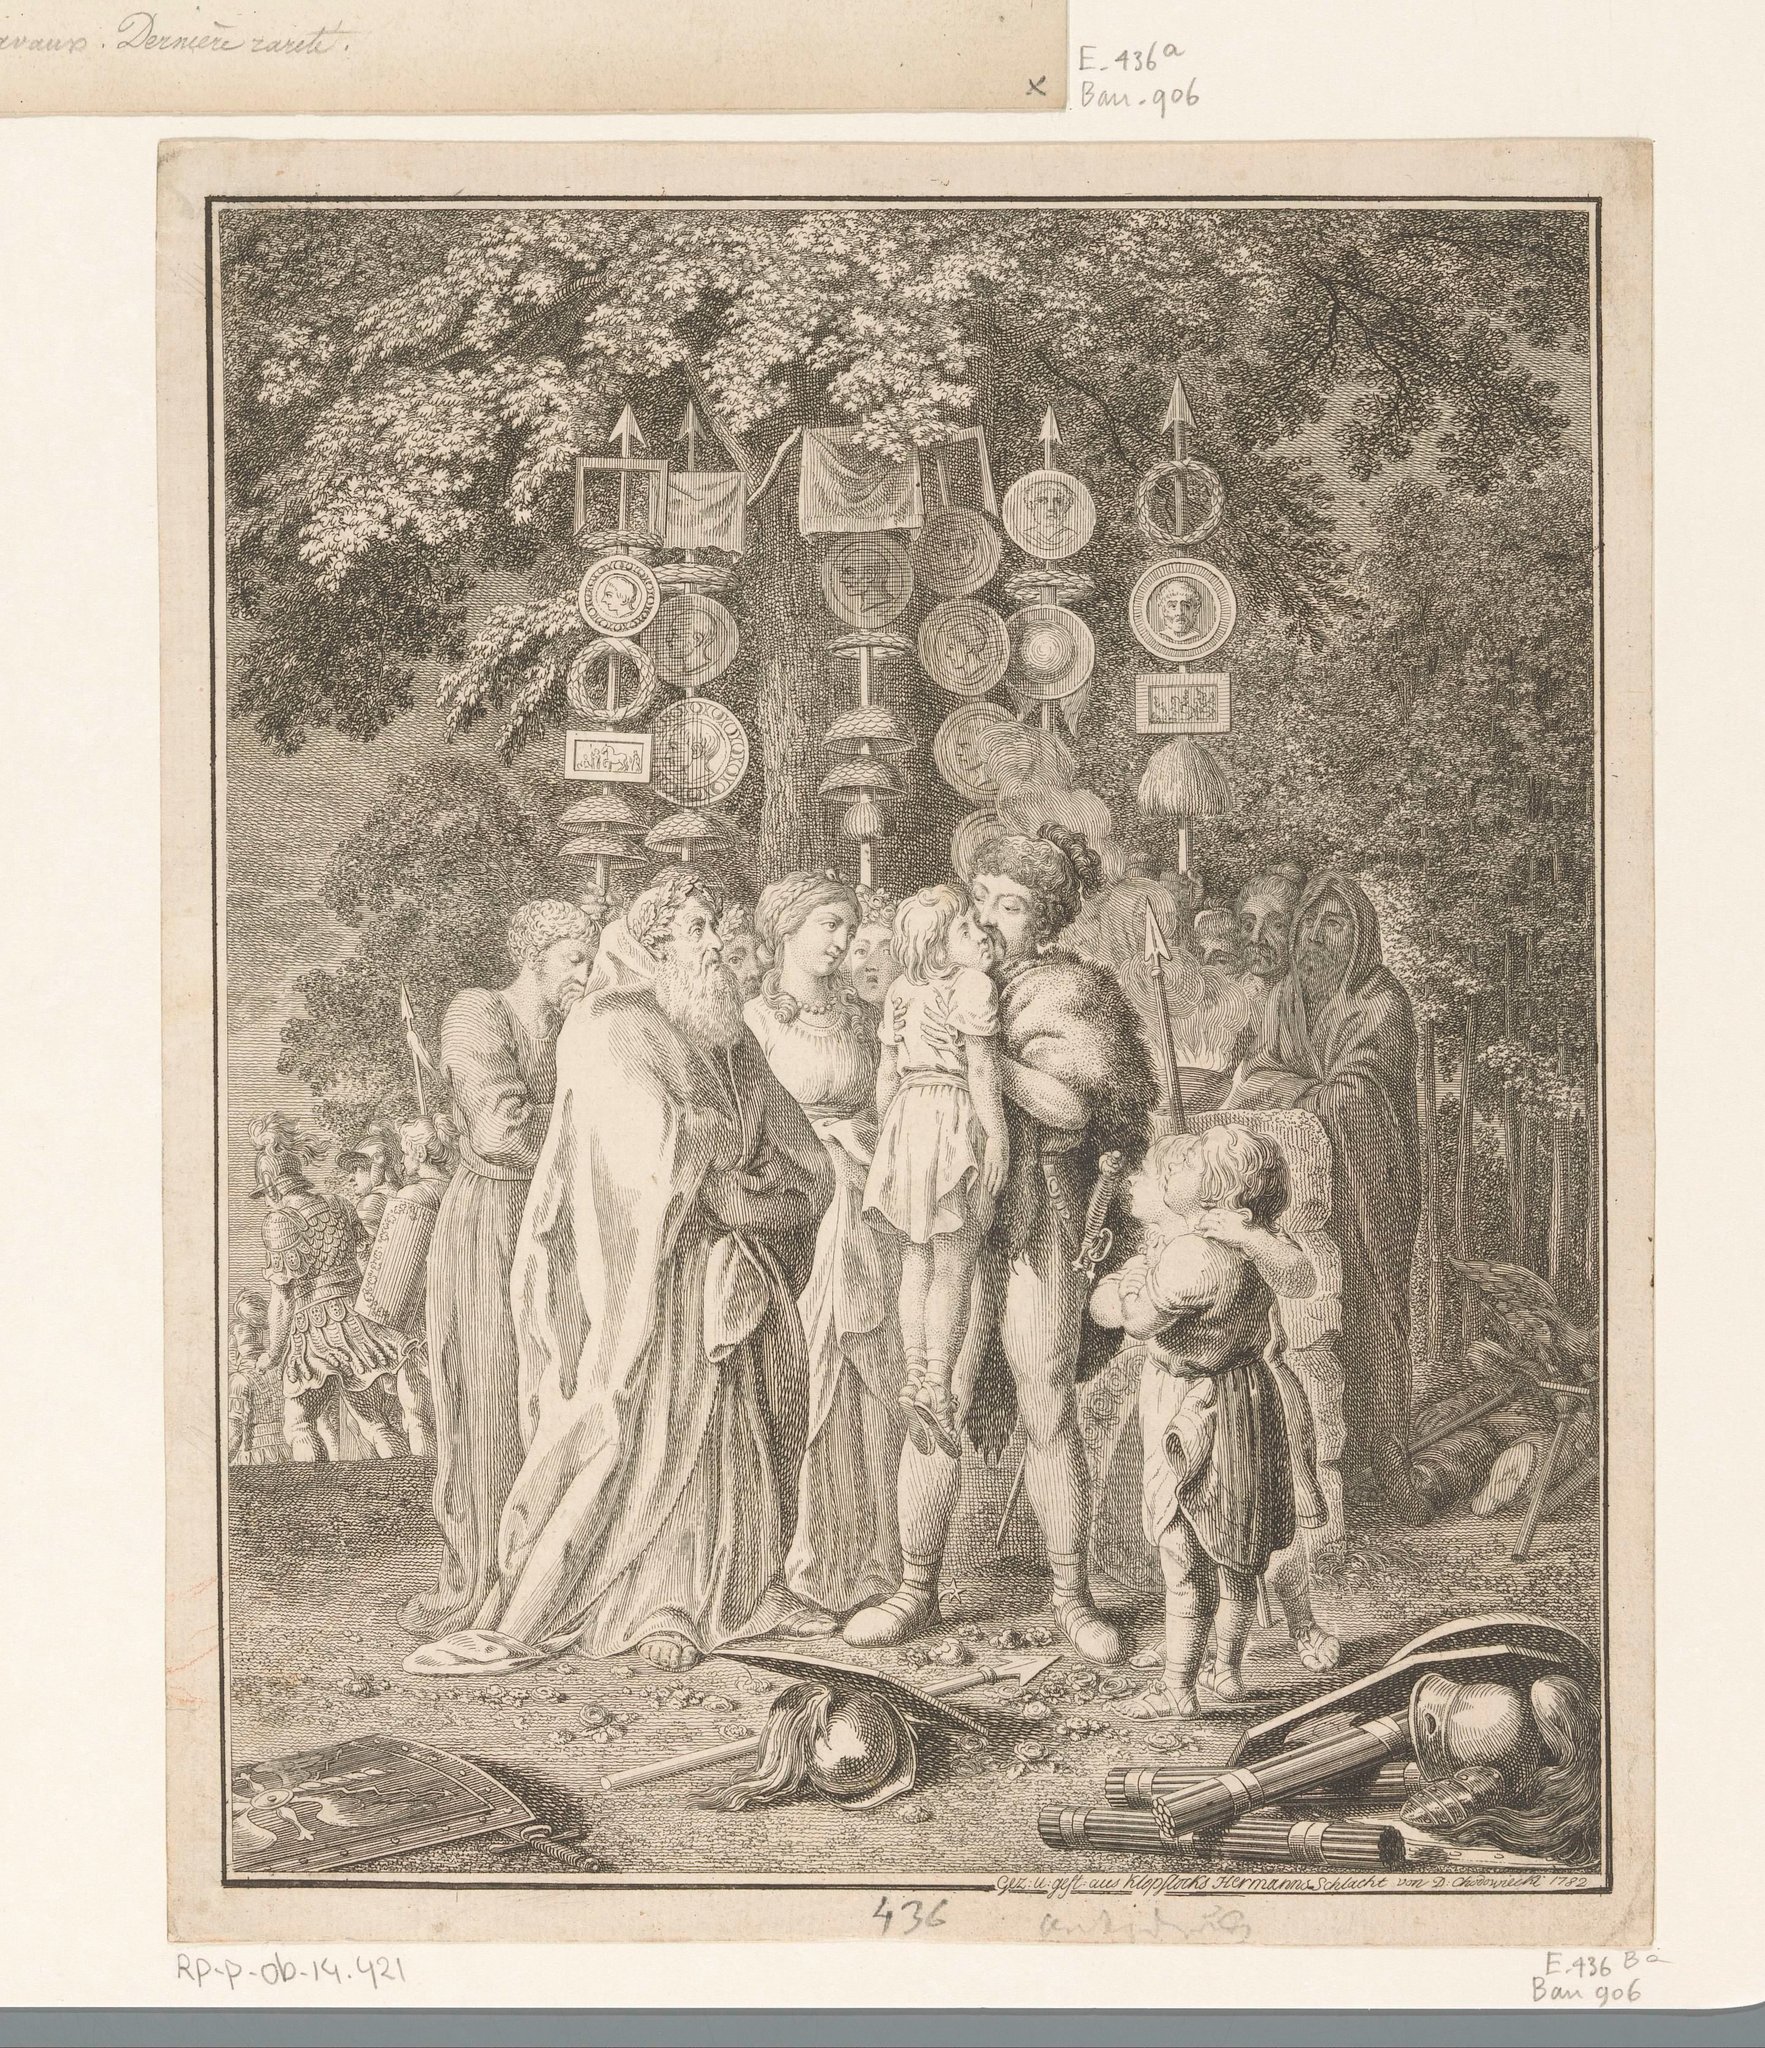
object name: print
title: Germaanse veldheer Arminius kust voor de heilige eik een verwonde schildknaap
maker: daniel nikolaus chodowiecki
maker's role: draughtsman, print maker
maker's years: 1726-1801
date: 1782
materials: paper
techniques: etching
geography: berlin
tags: helmet, protective weapons: shield, germanic and scandinavian religions, religious functionaries ~ germanic and scandiavian religions, trees: oak, (military) flags and standards, victory ~ armed conflict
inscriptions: collector's mark: Lugt 2228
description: Prent gebruikt voor: Klein, Anton. Leben und Bildnisse der Grossen Deutschen, von verschiedenen Verfassern und Künstlern (...). 3 dln. Mannheim: s.n., 1785, dl. 1.